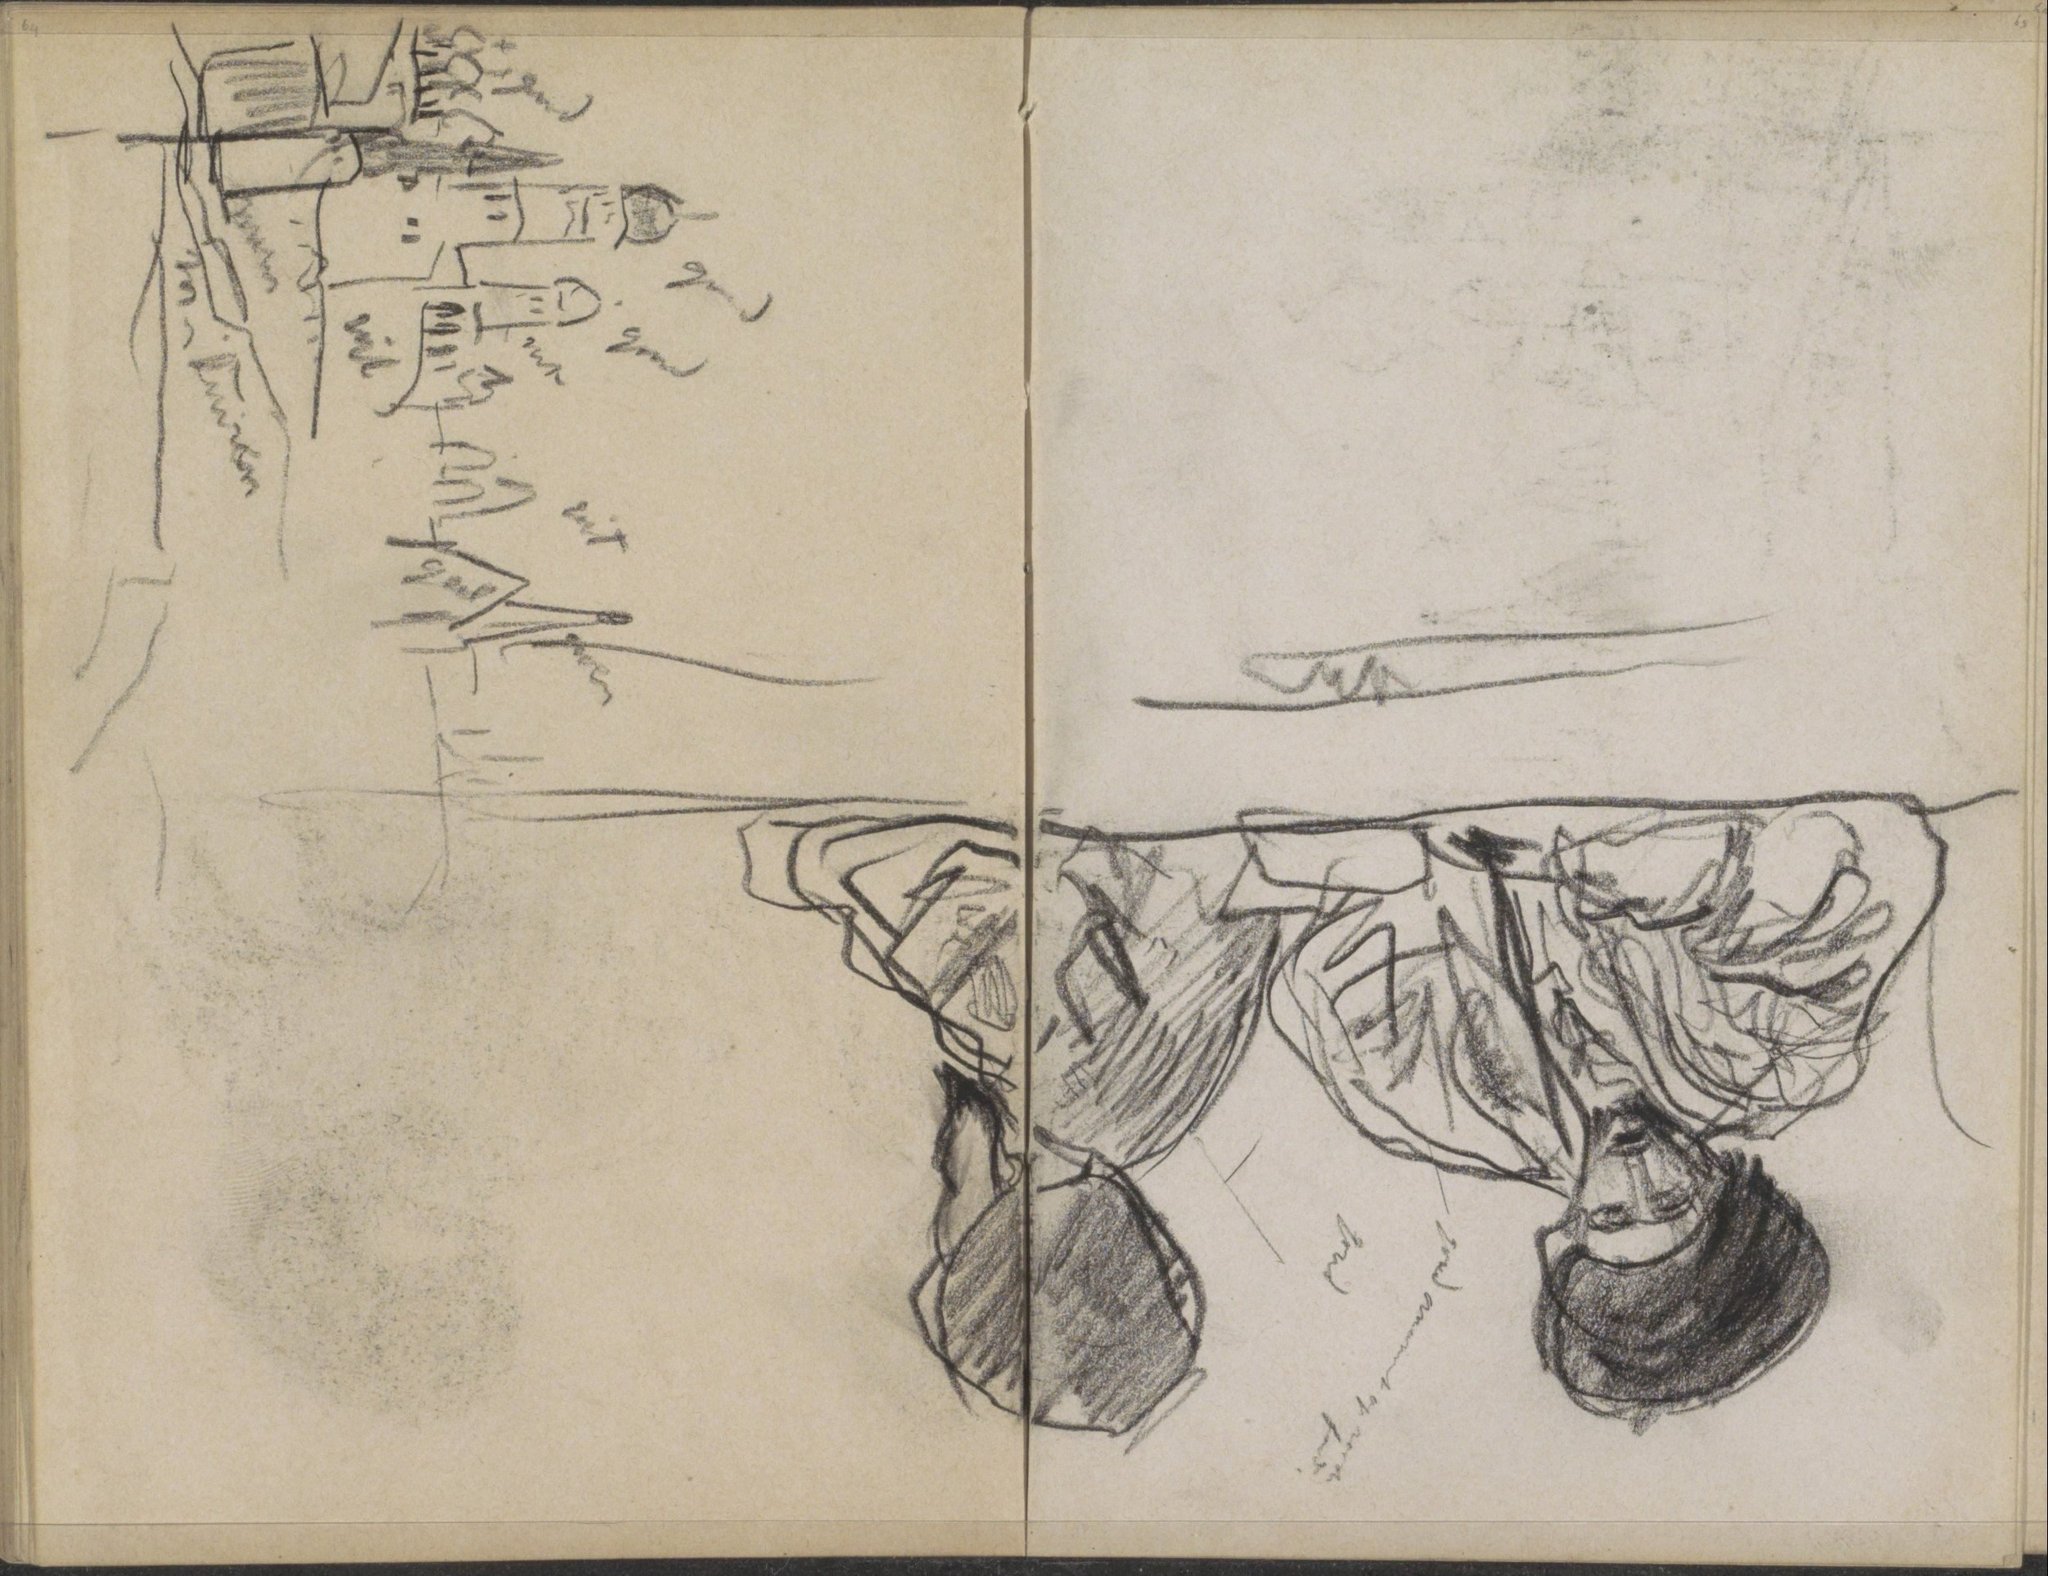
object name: sketchbook leaf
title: Twee mannen in oosterse kleding en torens van het Kremlin van Moskou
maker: marius bauer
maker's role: draughtsman, print maker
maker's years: 1867-1932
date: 1896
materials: chalk, paper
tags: city-view, and landscape with man-made constructions, adult man, head-gear: turban, folk costume, regional costume, dome ~ architecture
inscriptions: kleurnotitie, handgeschreven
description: Pagina 64 en 65 uit een schetsboek met 45 bladen.